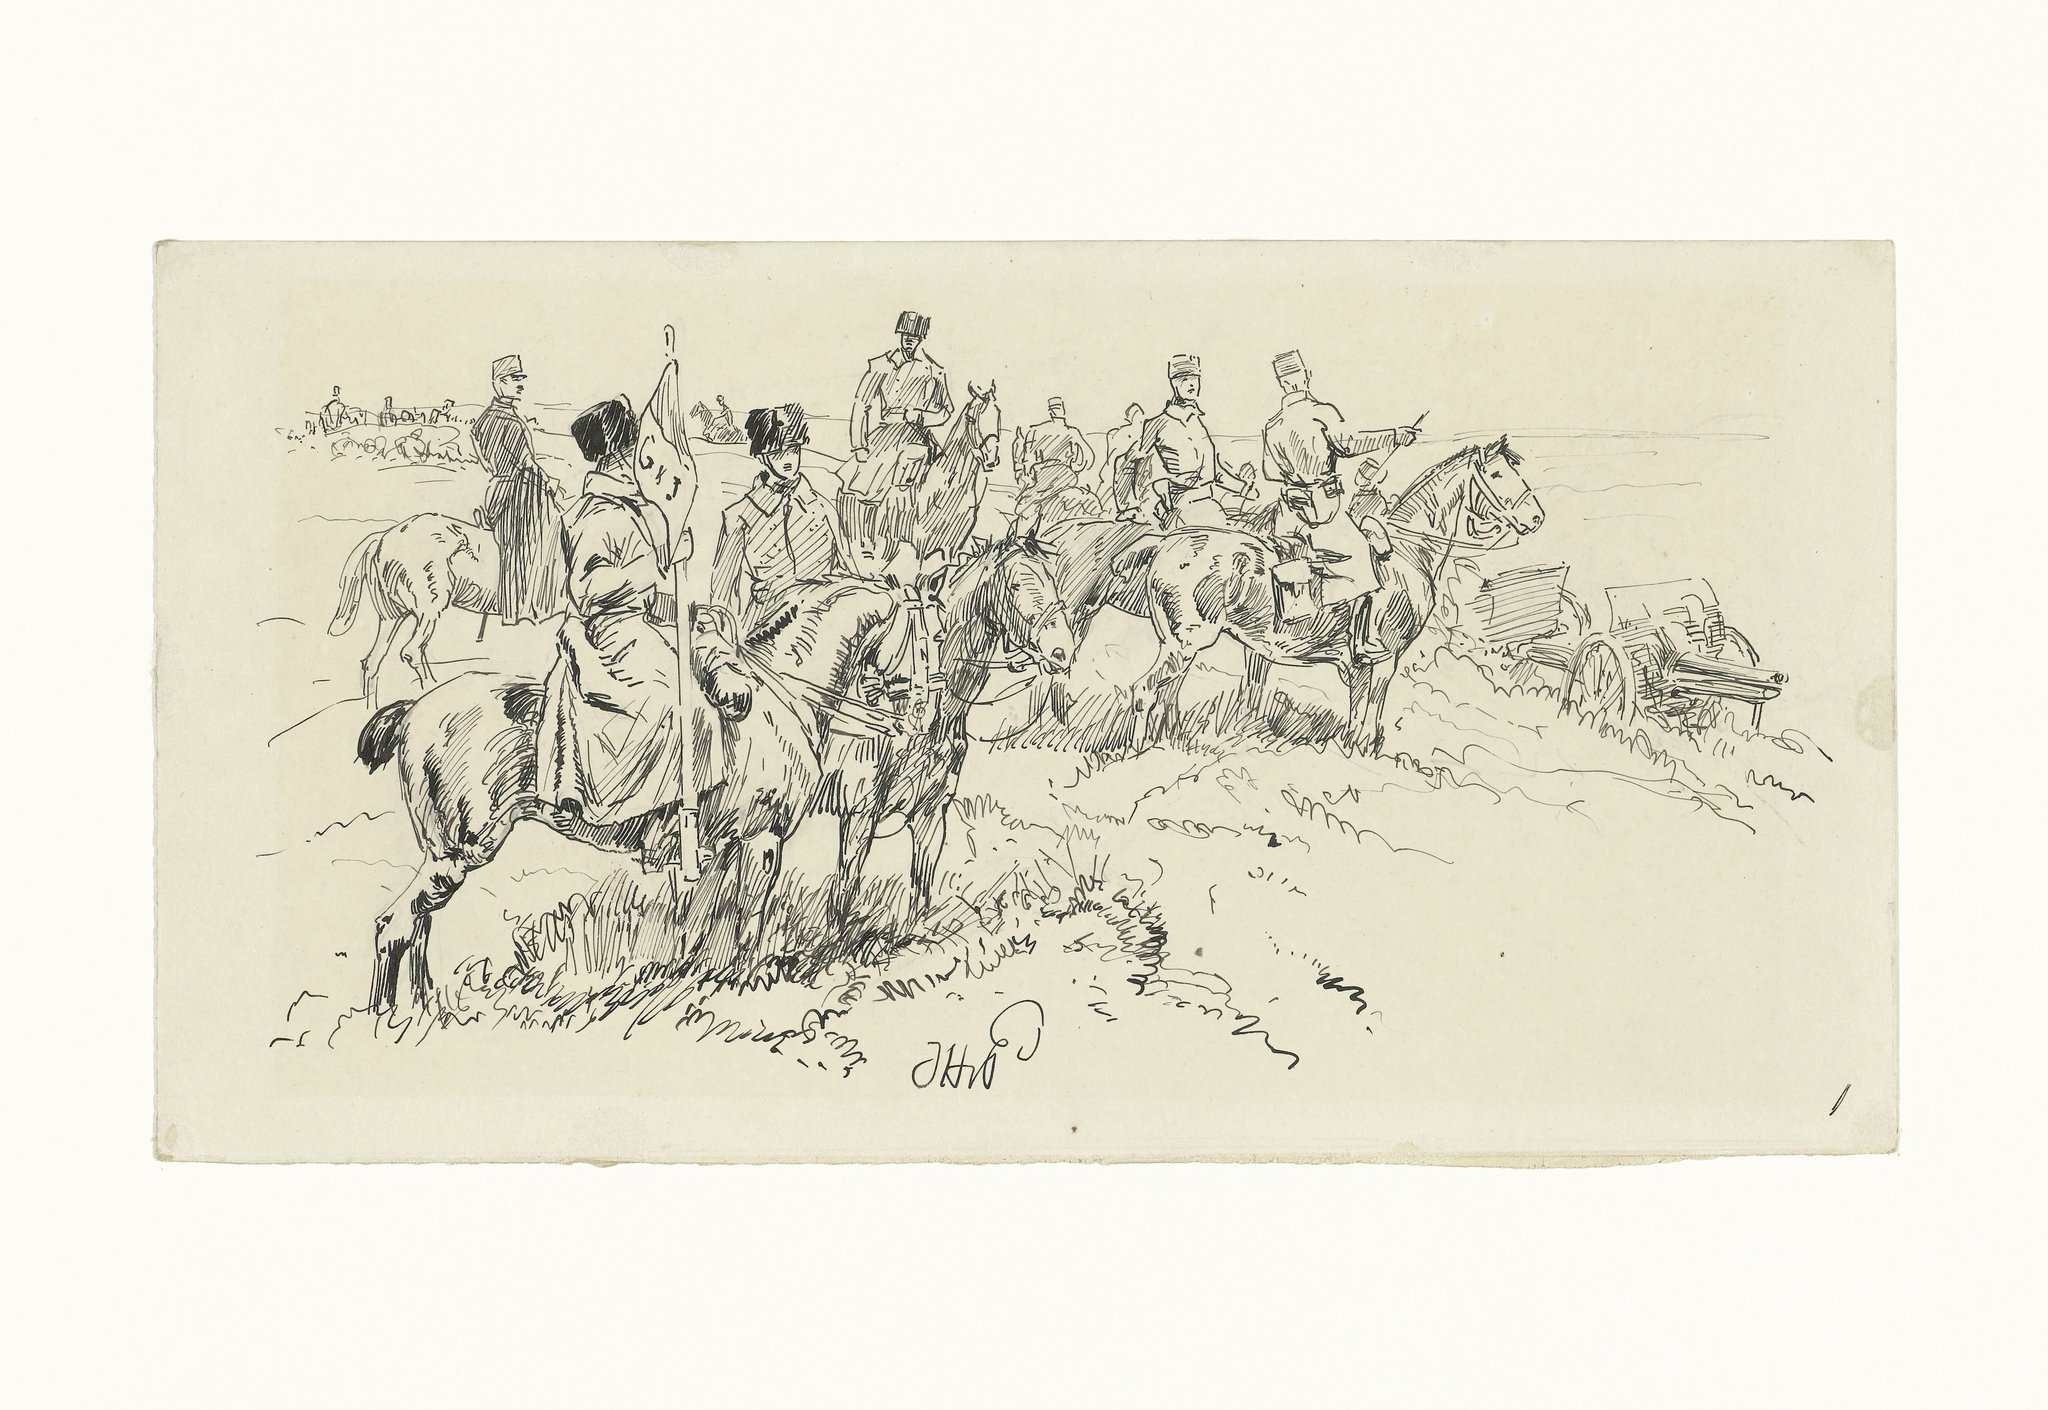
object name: drawing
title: Artillerie te velde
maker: jan hoynck van papendrecht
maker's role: draughtsman, painter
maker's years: 1858-1933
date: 1868-1933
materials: ink, paper, pencil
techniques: pen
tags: land forces (+ artillery)